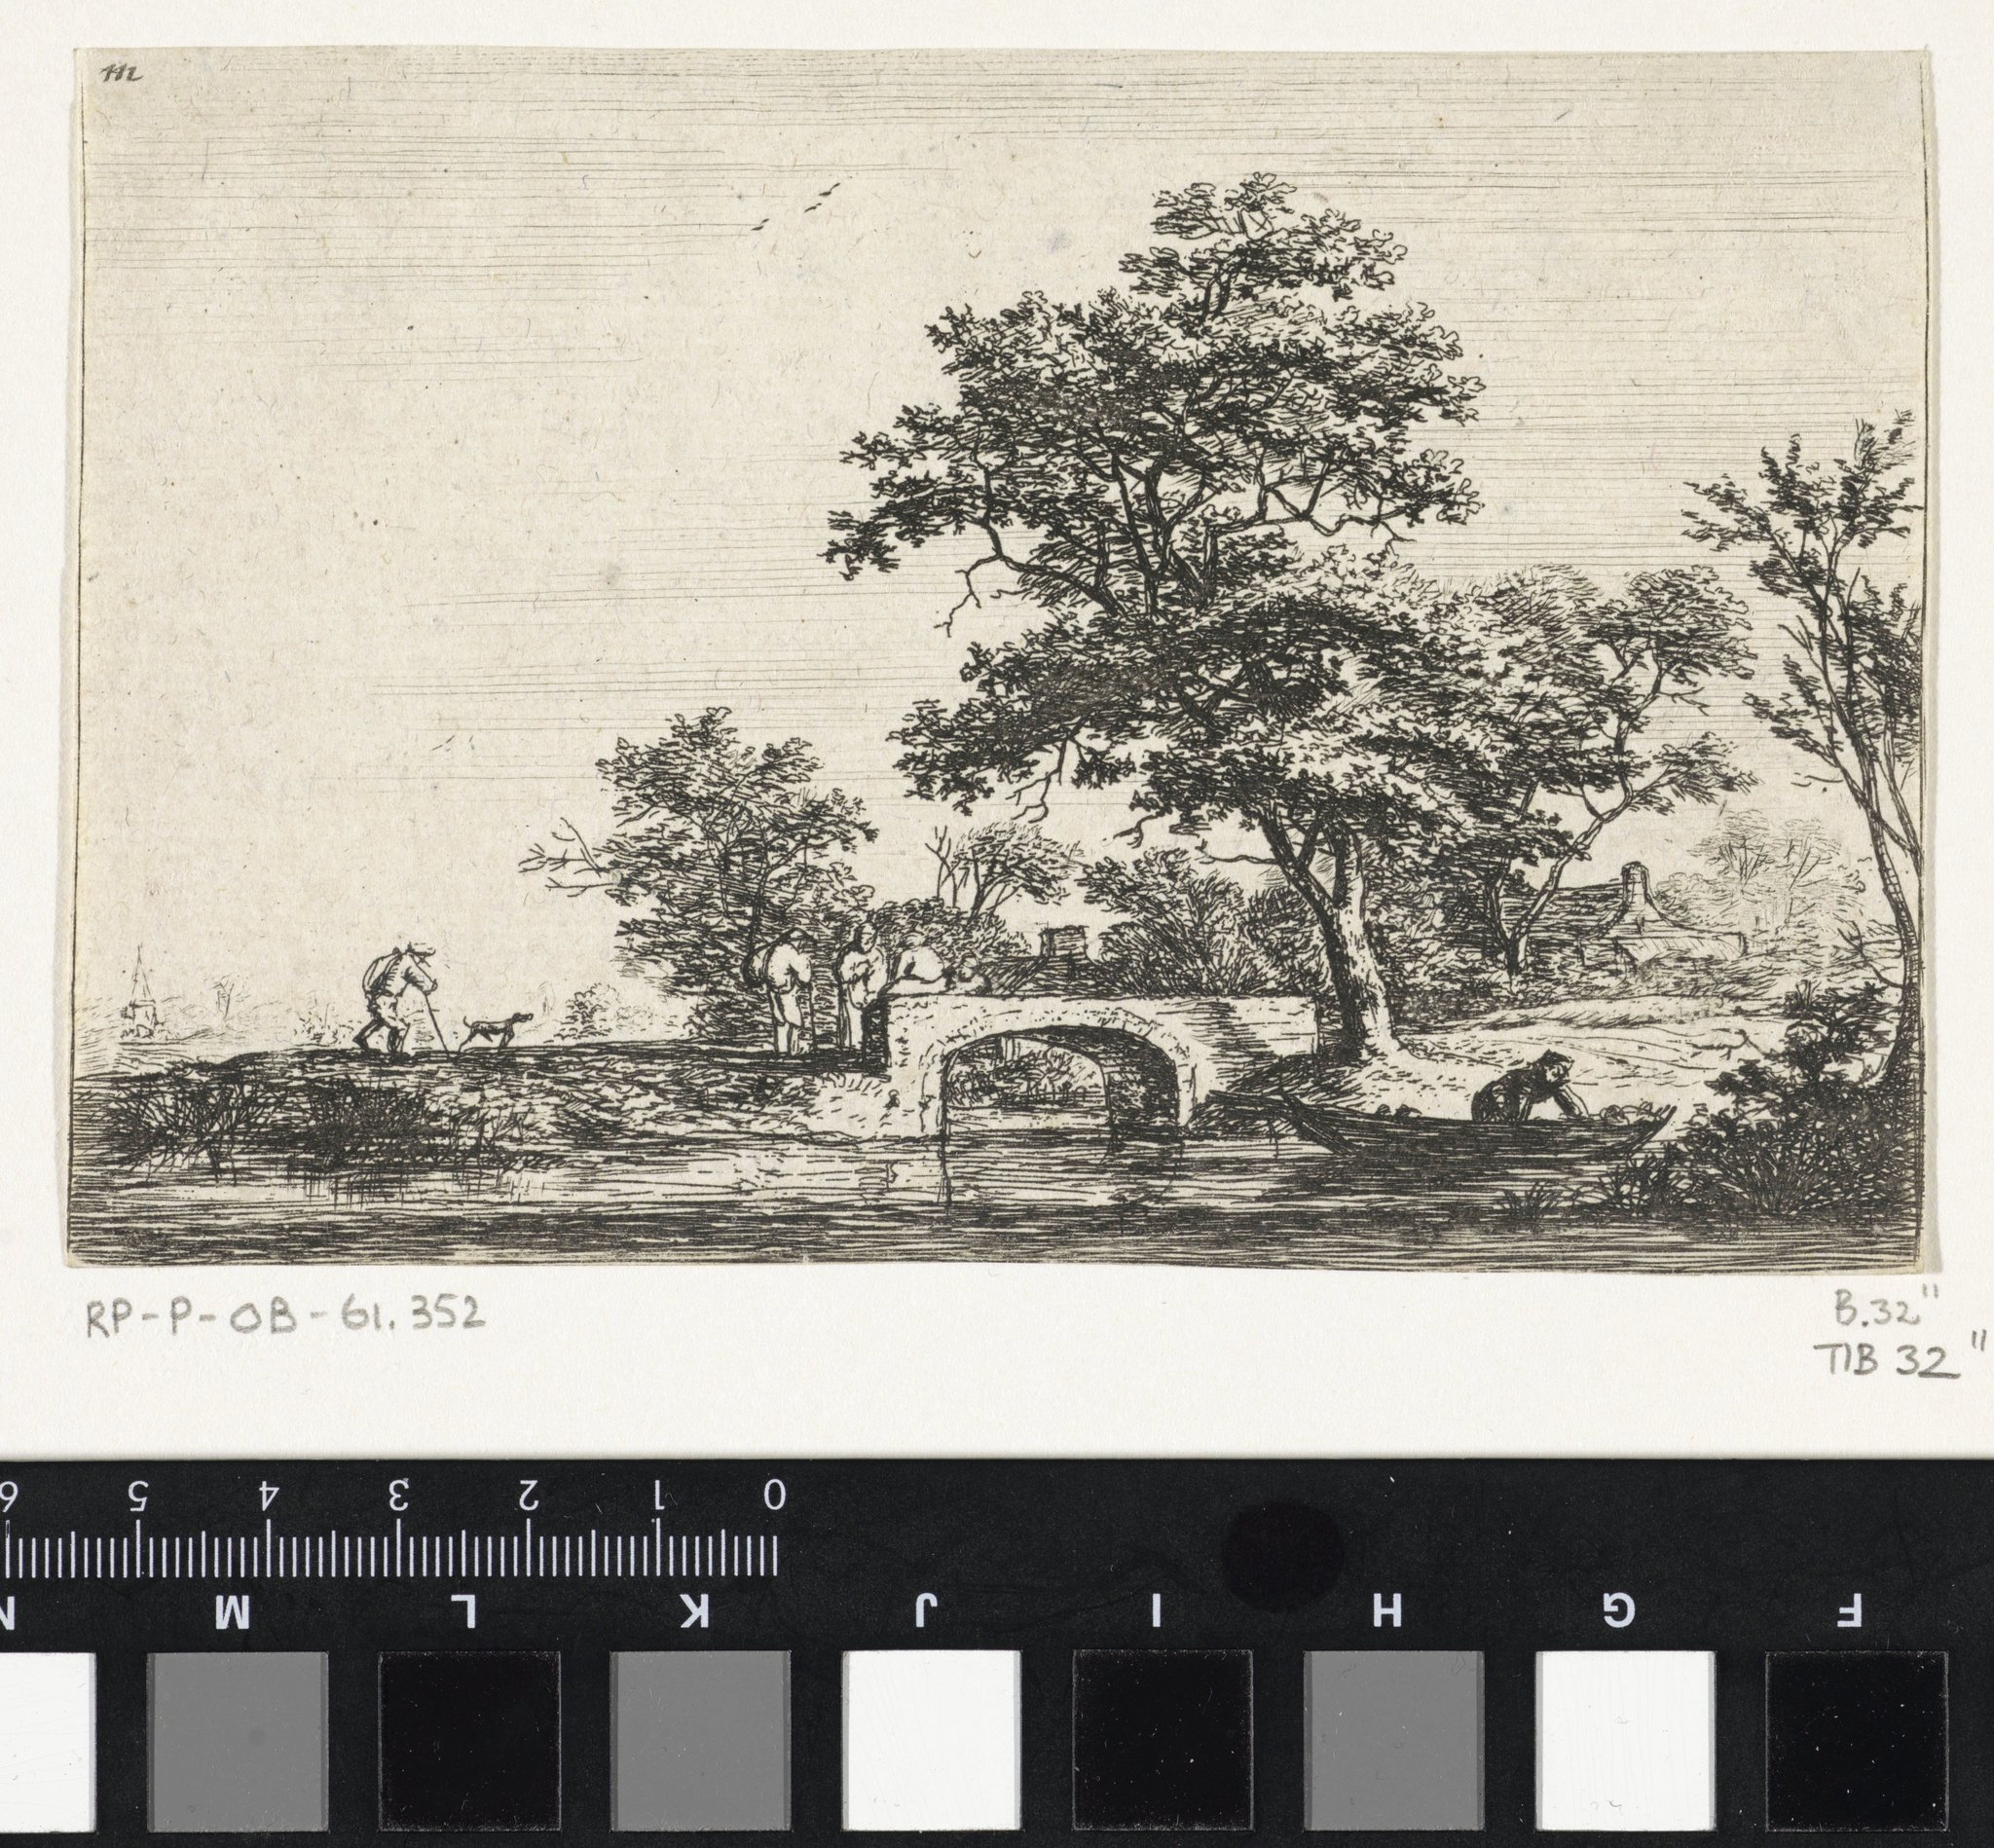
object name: print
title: Landschappen met figuren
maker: anthonie waterloo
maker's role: draughtsman, painter, print maker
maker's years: 1609-1690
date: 1630-1663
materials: paper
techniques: etching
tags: landscape with bridge, viaduct or aqueduct, landscapes with waters, waterscapes, seascapes (in the temperate zone), village, rowing-boat, canoe, etc., 'en route', traveller under way, landscapes (+ landscape with figures, staffage)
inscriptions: collector's mark: Lugt 2228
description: Een stenen brug over het water leidt naar een dorp. Bij de brug zijn drie figuren afgebeeld en links komt een vierde persoon met een hond aangelopen. Rechtsvoor is een man in een roeiboot weergegeven. Linksboven is de letter m te zien.